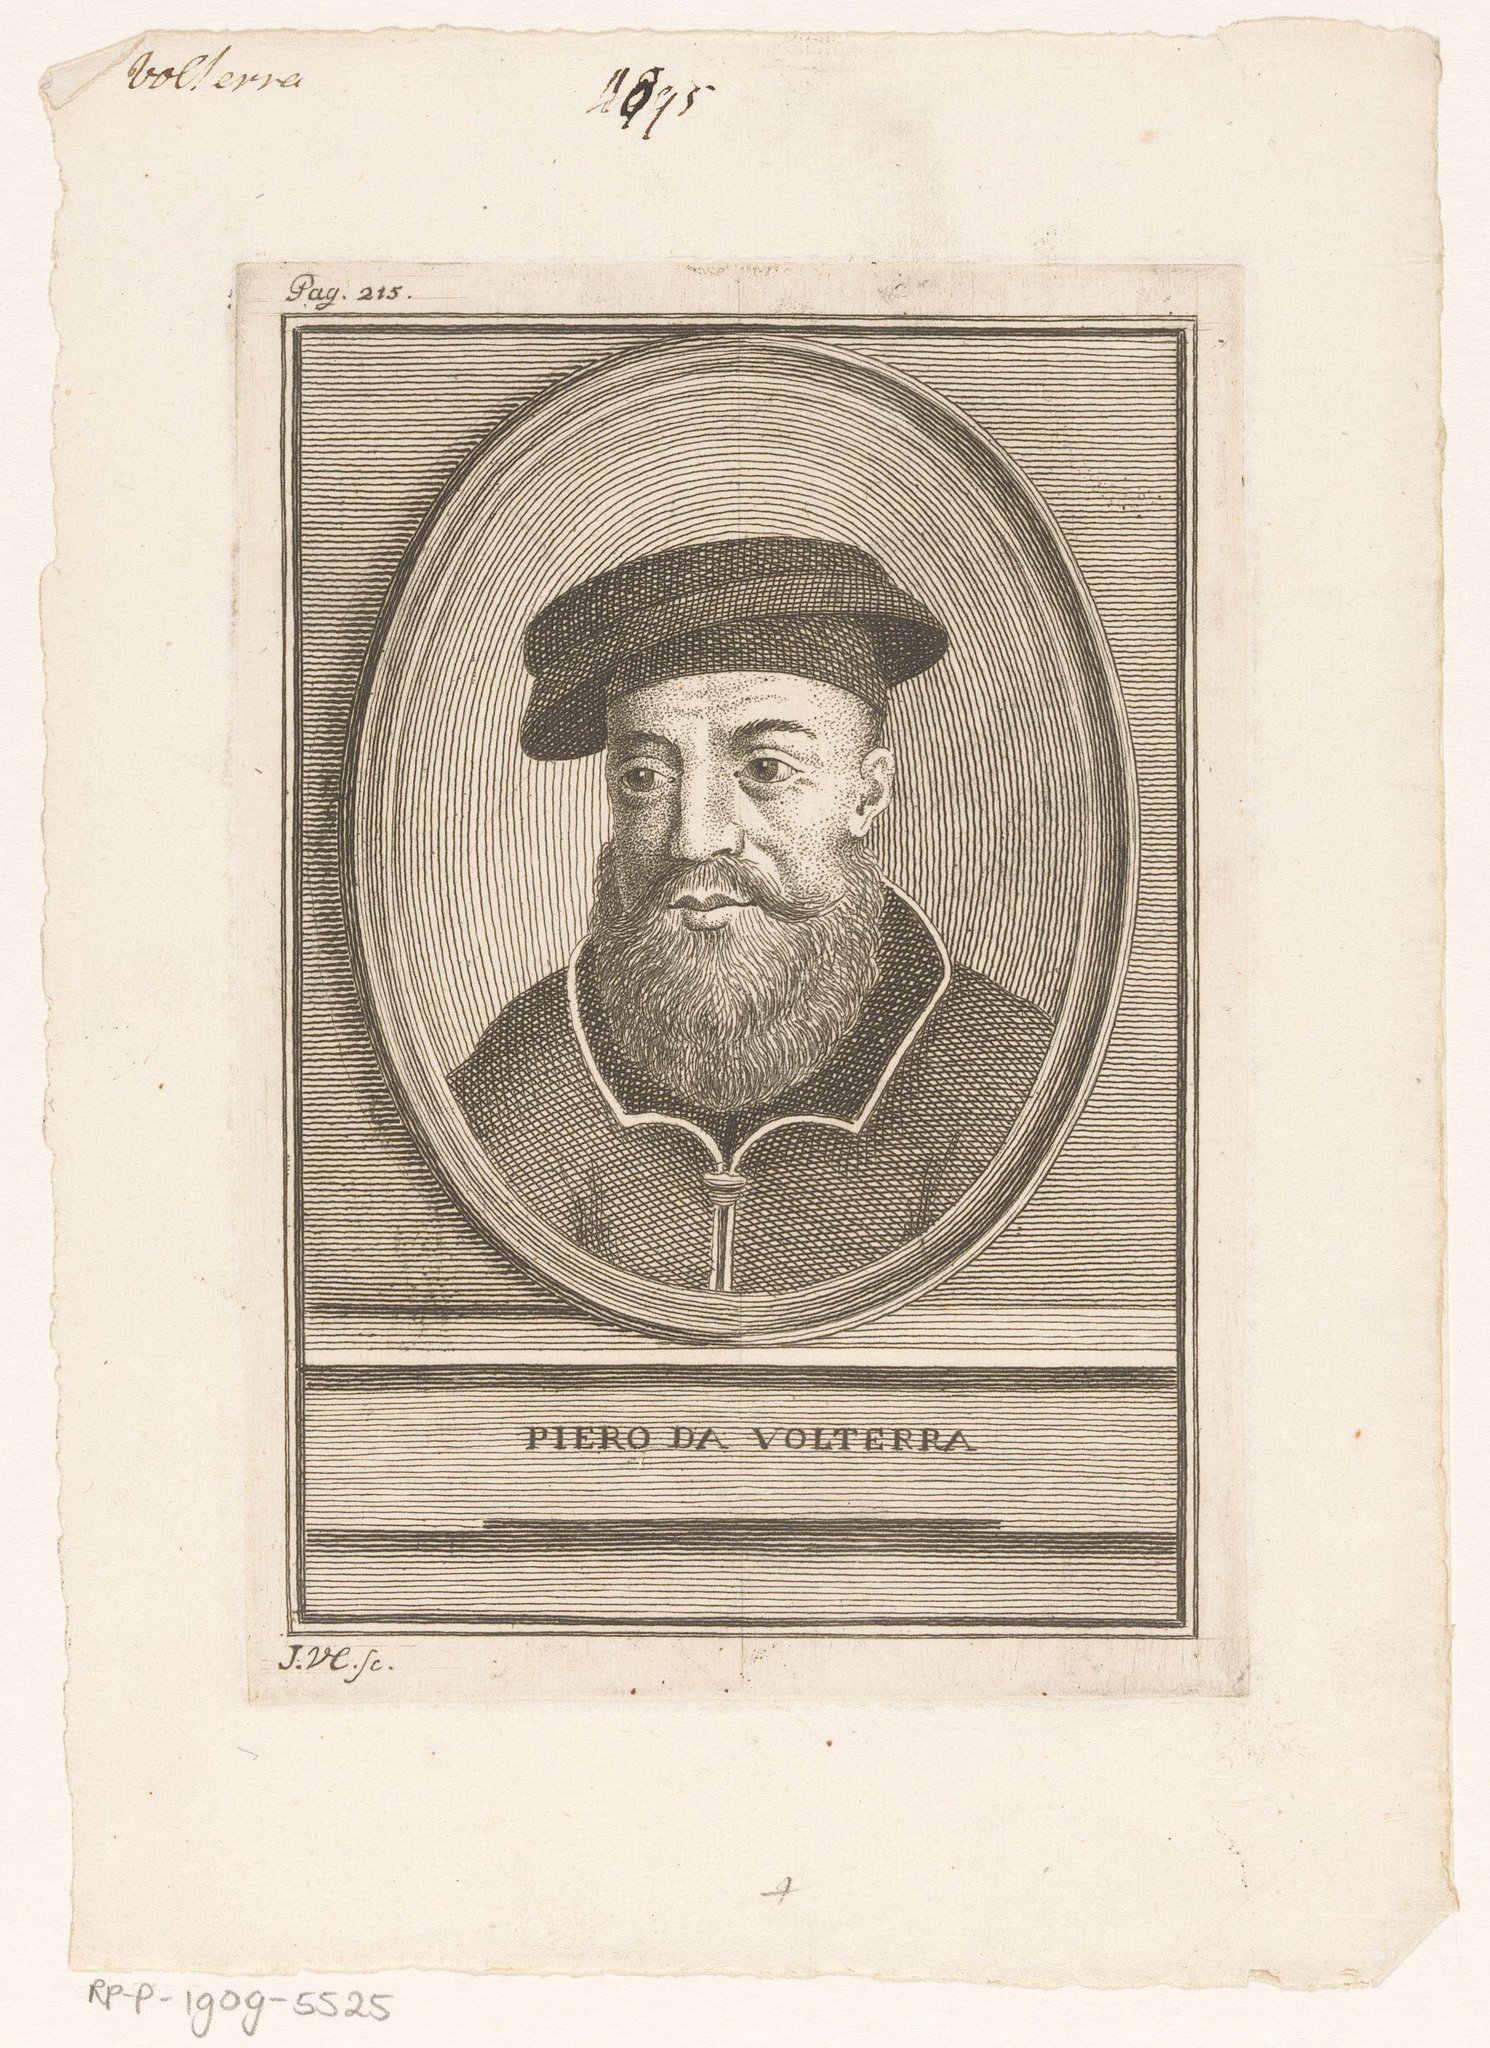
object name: print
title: Portret van liedschrijver Piero da Volterra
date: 1750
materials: paper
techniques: engraving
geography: lucca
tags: historical persons, portrait of a writer, writer, poet, author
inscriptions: inscription: ‘Volterra / 4895’, collector's mark: Lugt 2228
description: Prent gebruikt voor Grazzini, Anton Francesco. Tutti i trionfi, carri, mascherate o canti carnascialeschi andati per Firenze dal tempo del Magnifico Lorenzo de' Medici fino all' anno 1559 : in questa seconda edizione corretti, con diversi MSS. collazionati, delle loro varie lezioni arricchiti, notabilmente accresciuti, e co' ritratti di ciascun poeta adornate. Lucca: Cosmopoli, 1750.